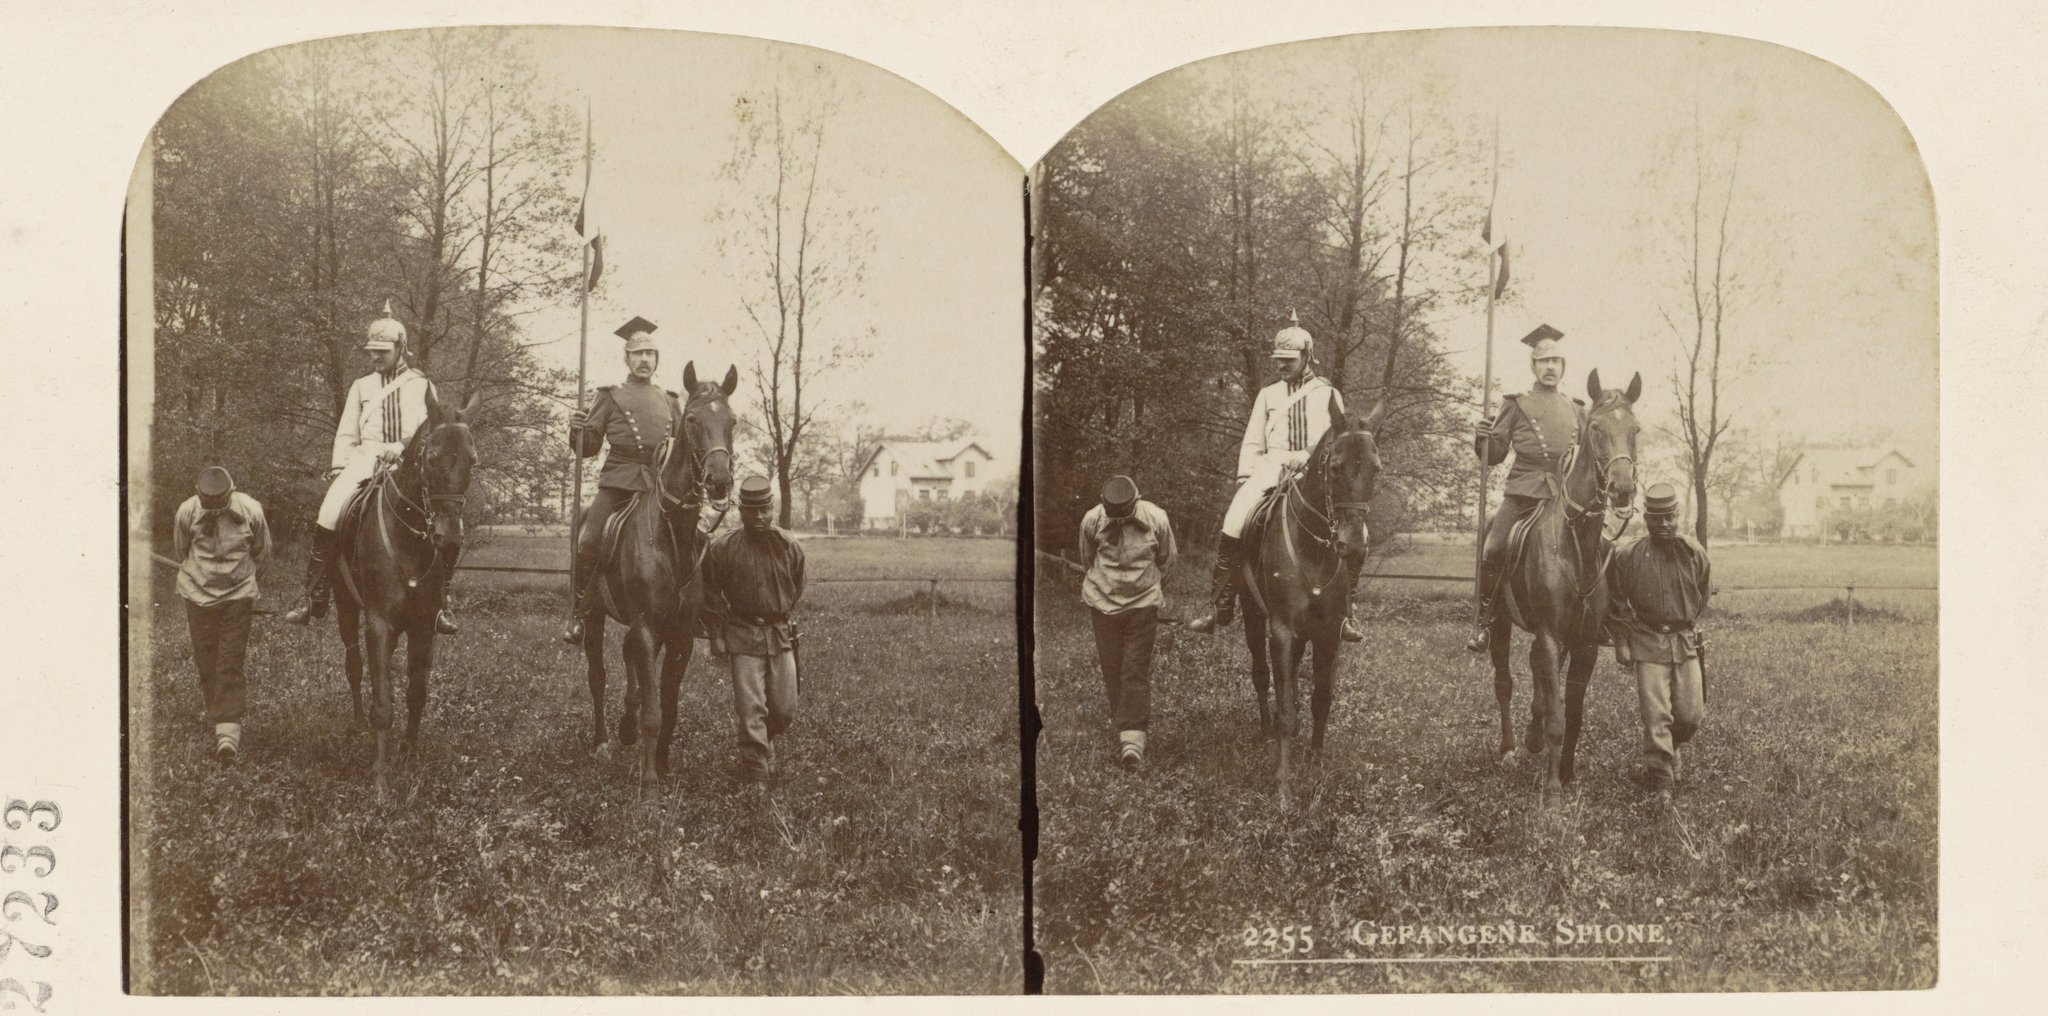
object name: stereograph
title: Twee mannen te paard met daarnaast twee gevangenen te voet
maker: Anonymous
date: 1873-1890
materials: cardboard, paper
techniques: albumen print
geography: germany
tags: riding a horse, ass, or mule; rider, horseman, arrest of (presumed) spy, germany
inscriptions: number: ‘2255’, number: ‘27233’